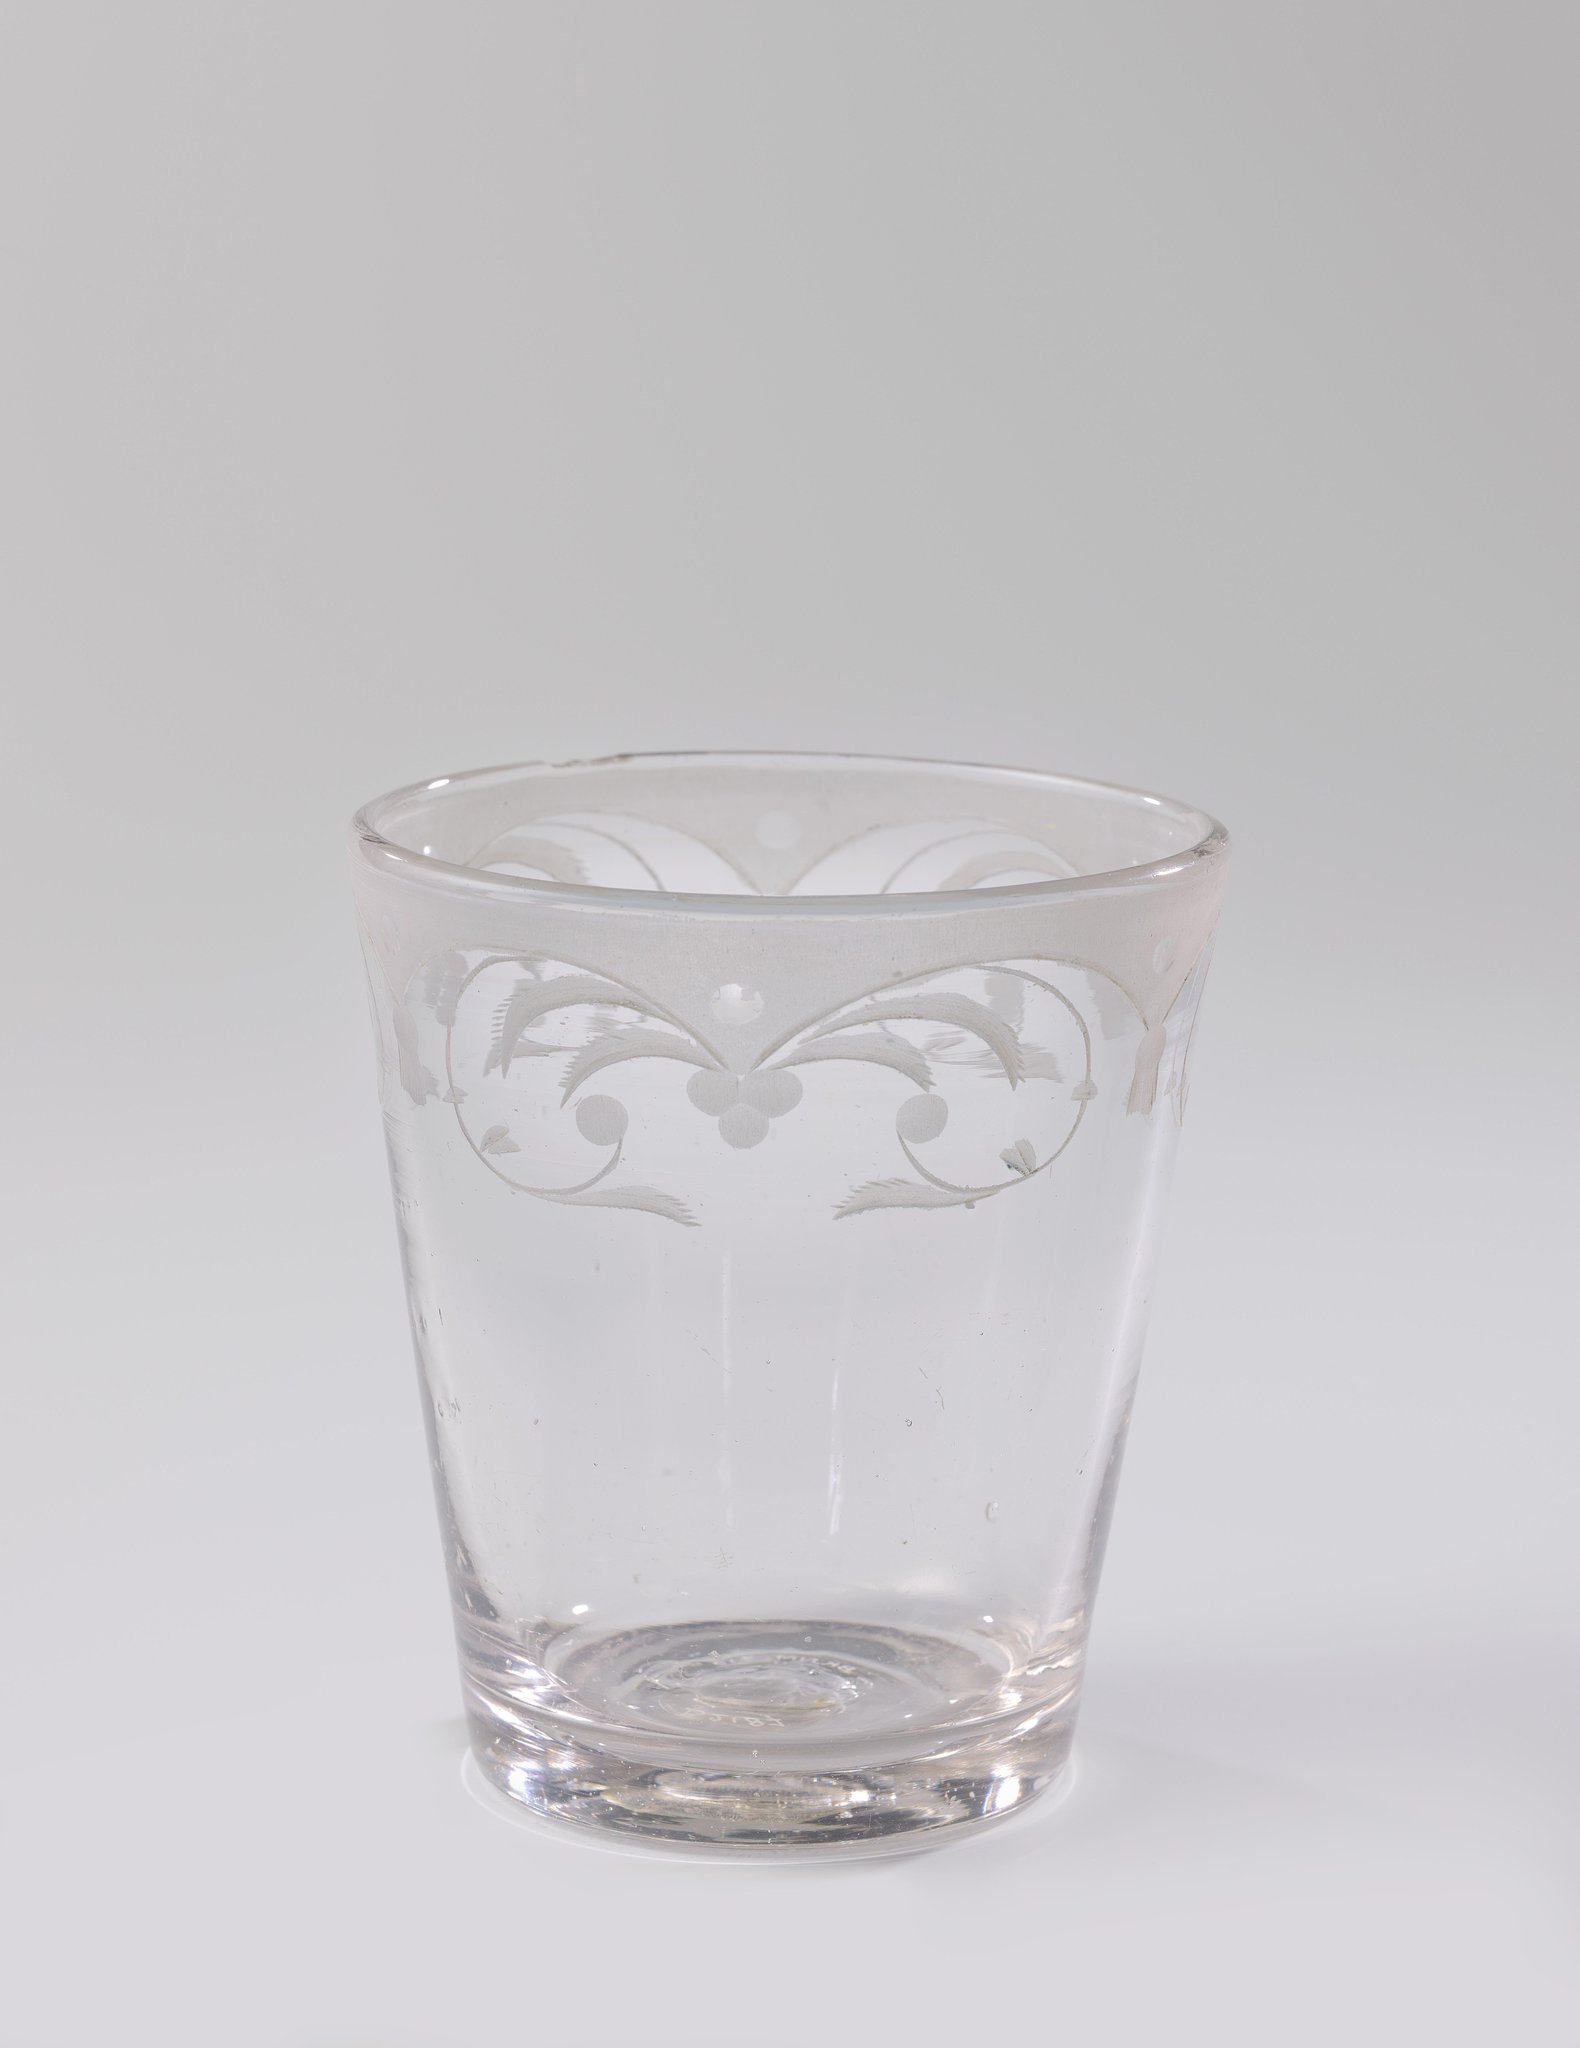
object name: cup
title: Beker met ornamentrand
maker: Anonymous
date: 1750-1800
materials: glass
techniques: glassblowing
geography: bohemia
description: Beker van helder, kleurloos glas. Langs de mondrand een gegraveerde ornamentrand.